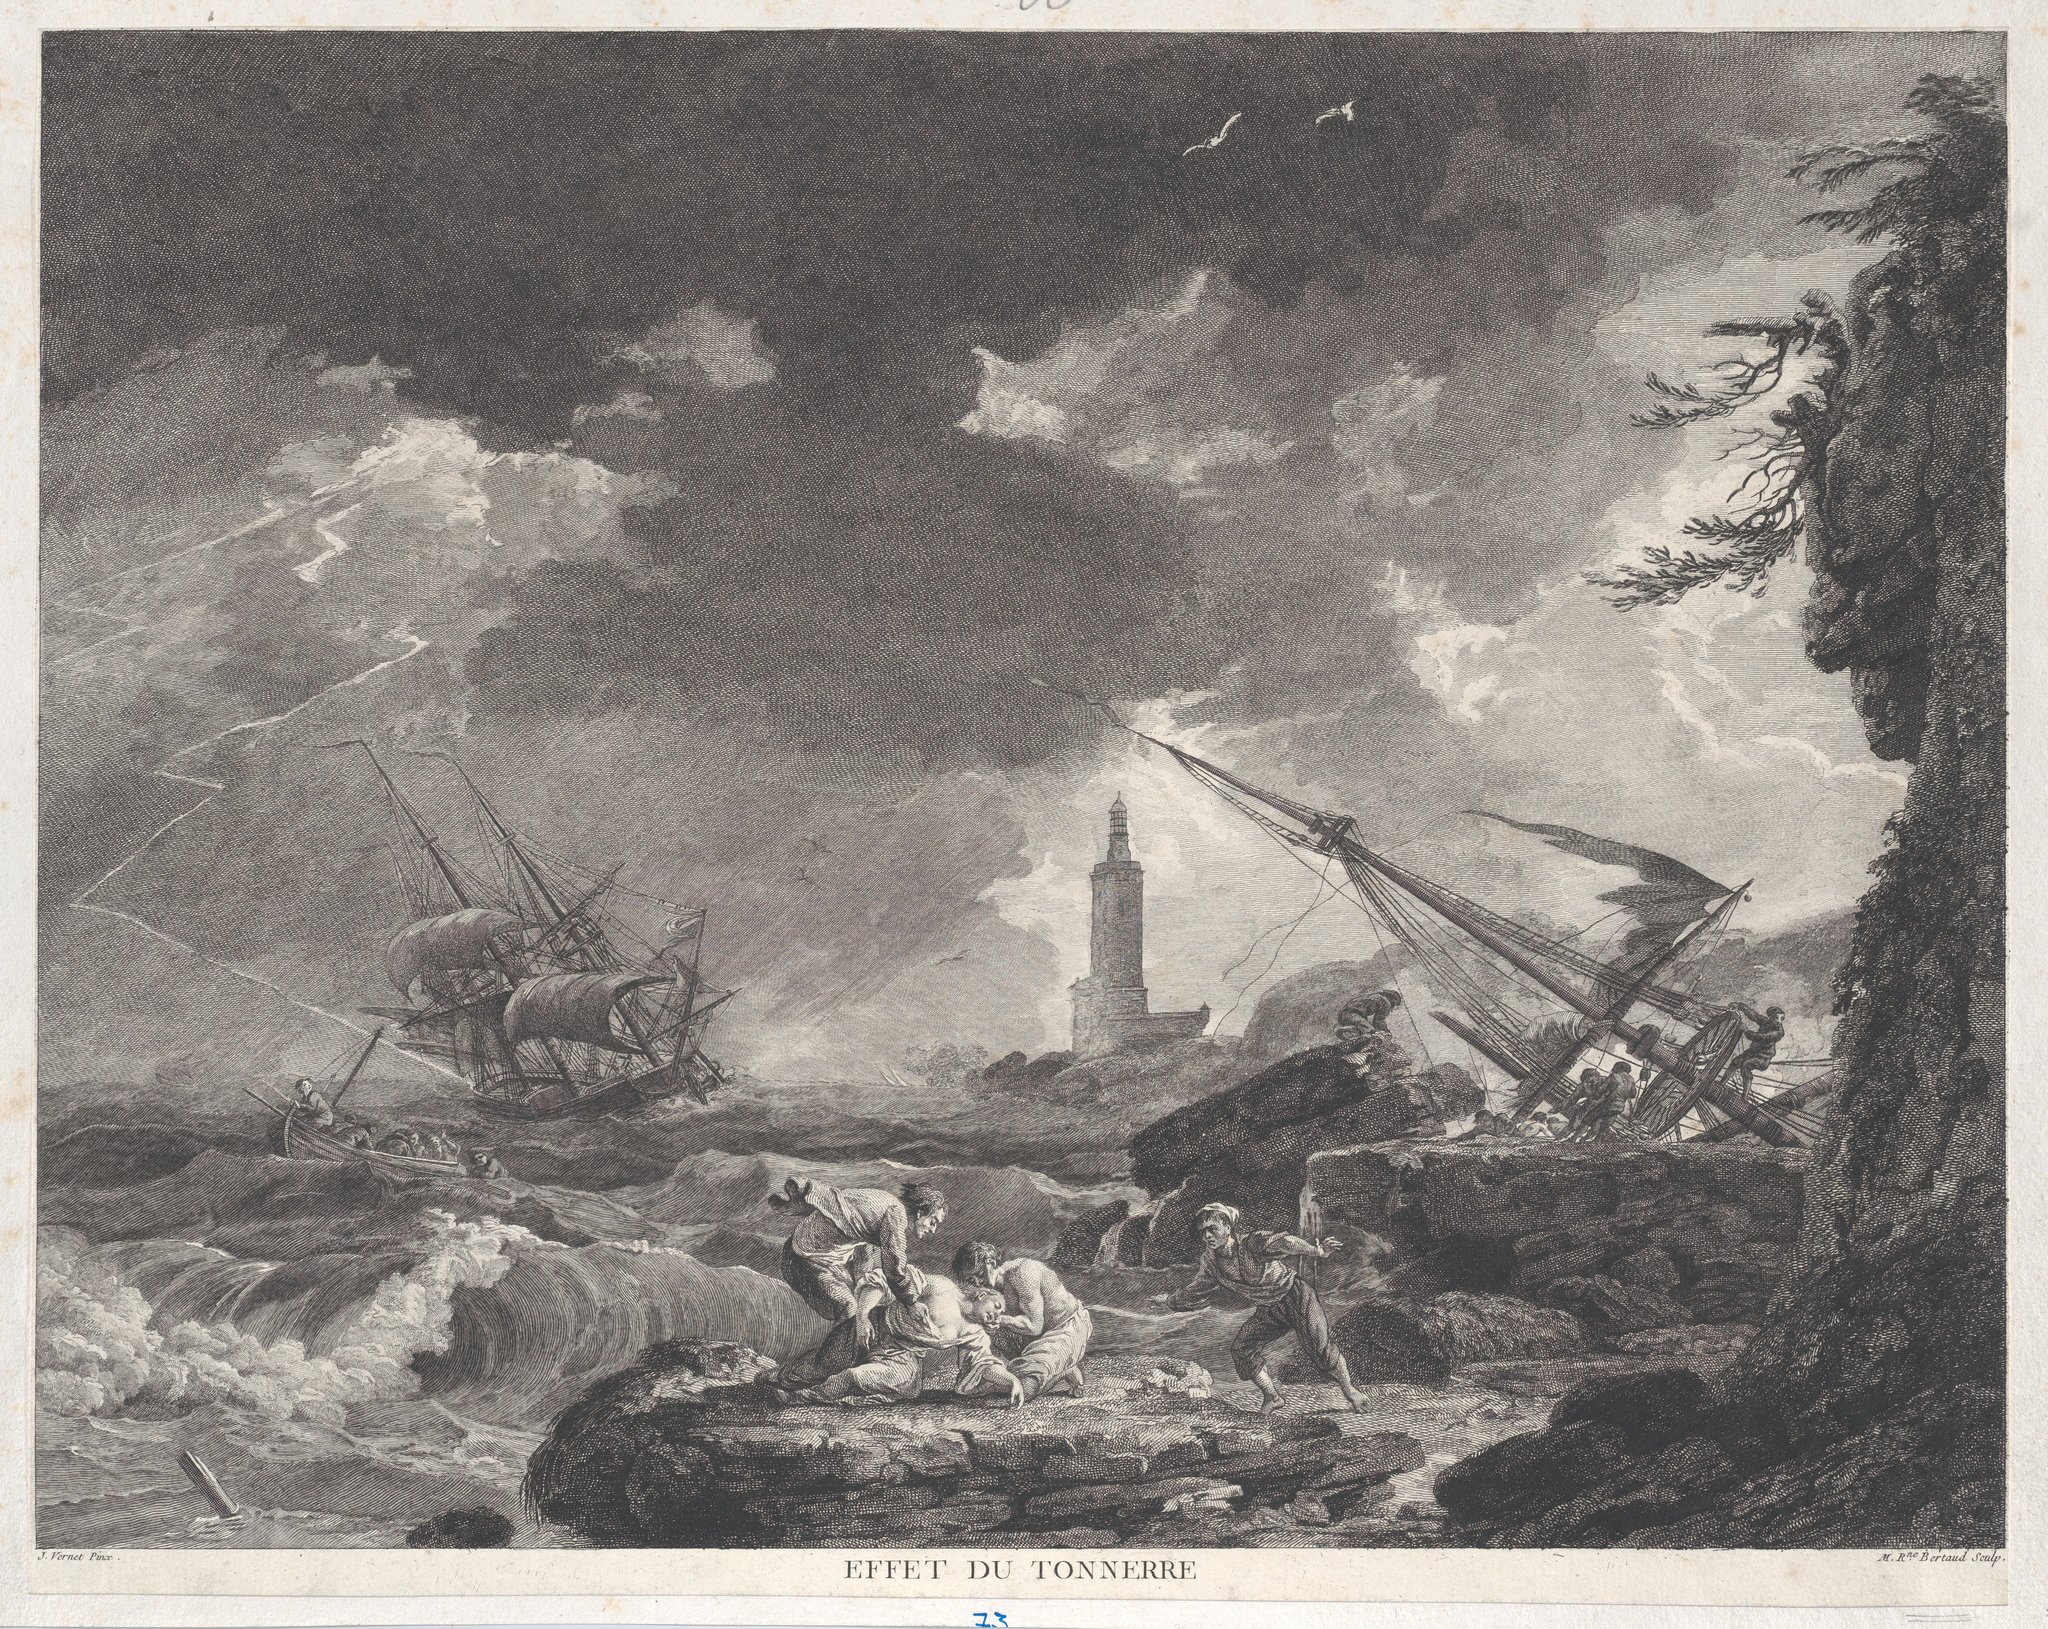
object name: print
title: Effect of Thunder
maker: joseph vernet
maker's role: artist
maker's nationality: french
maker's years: 1714-1789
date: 1755-1785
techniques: engraving